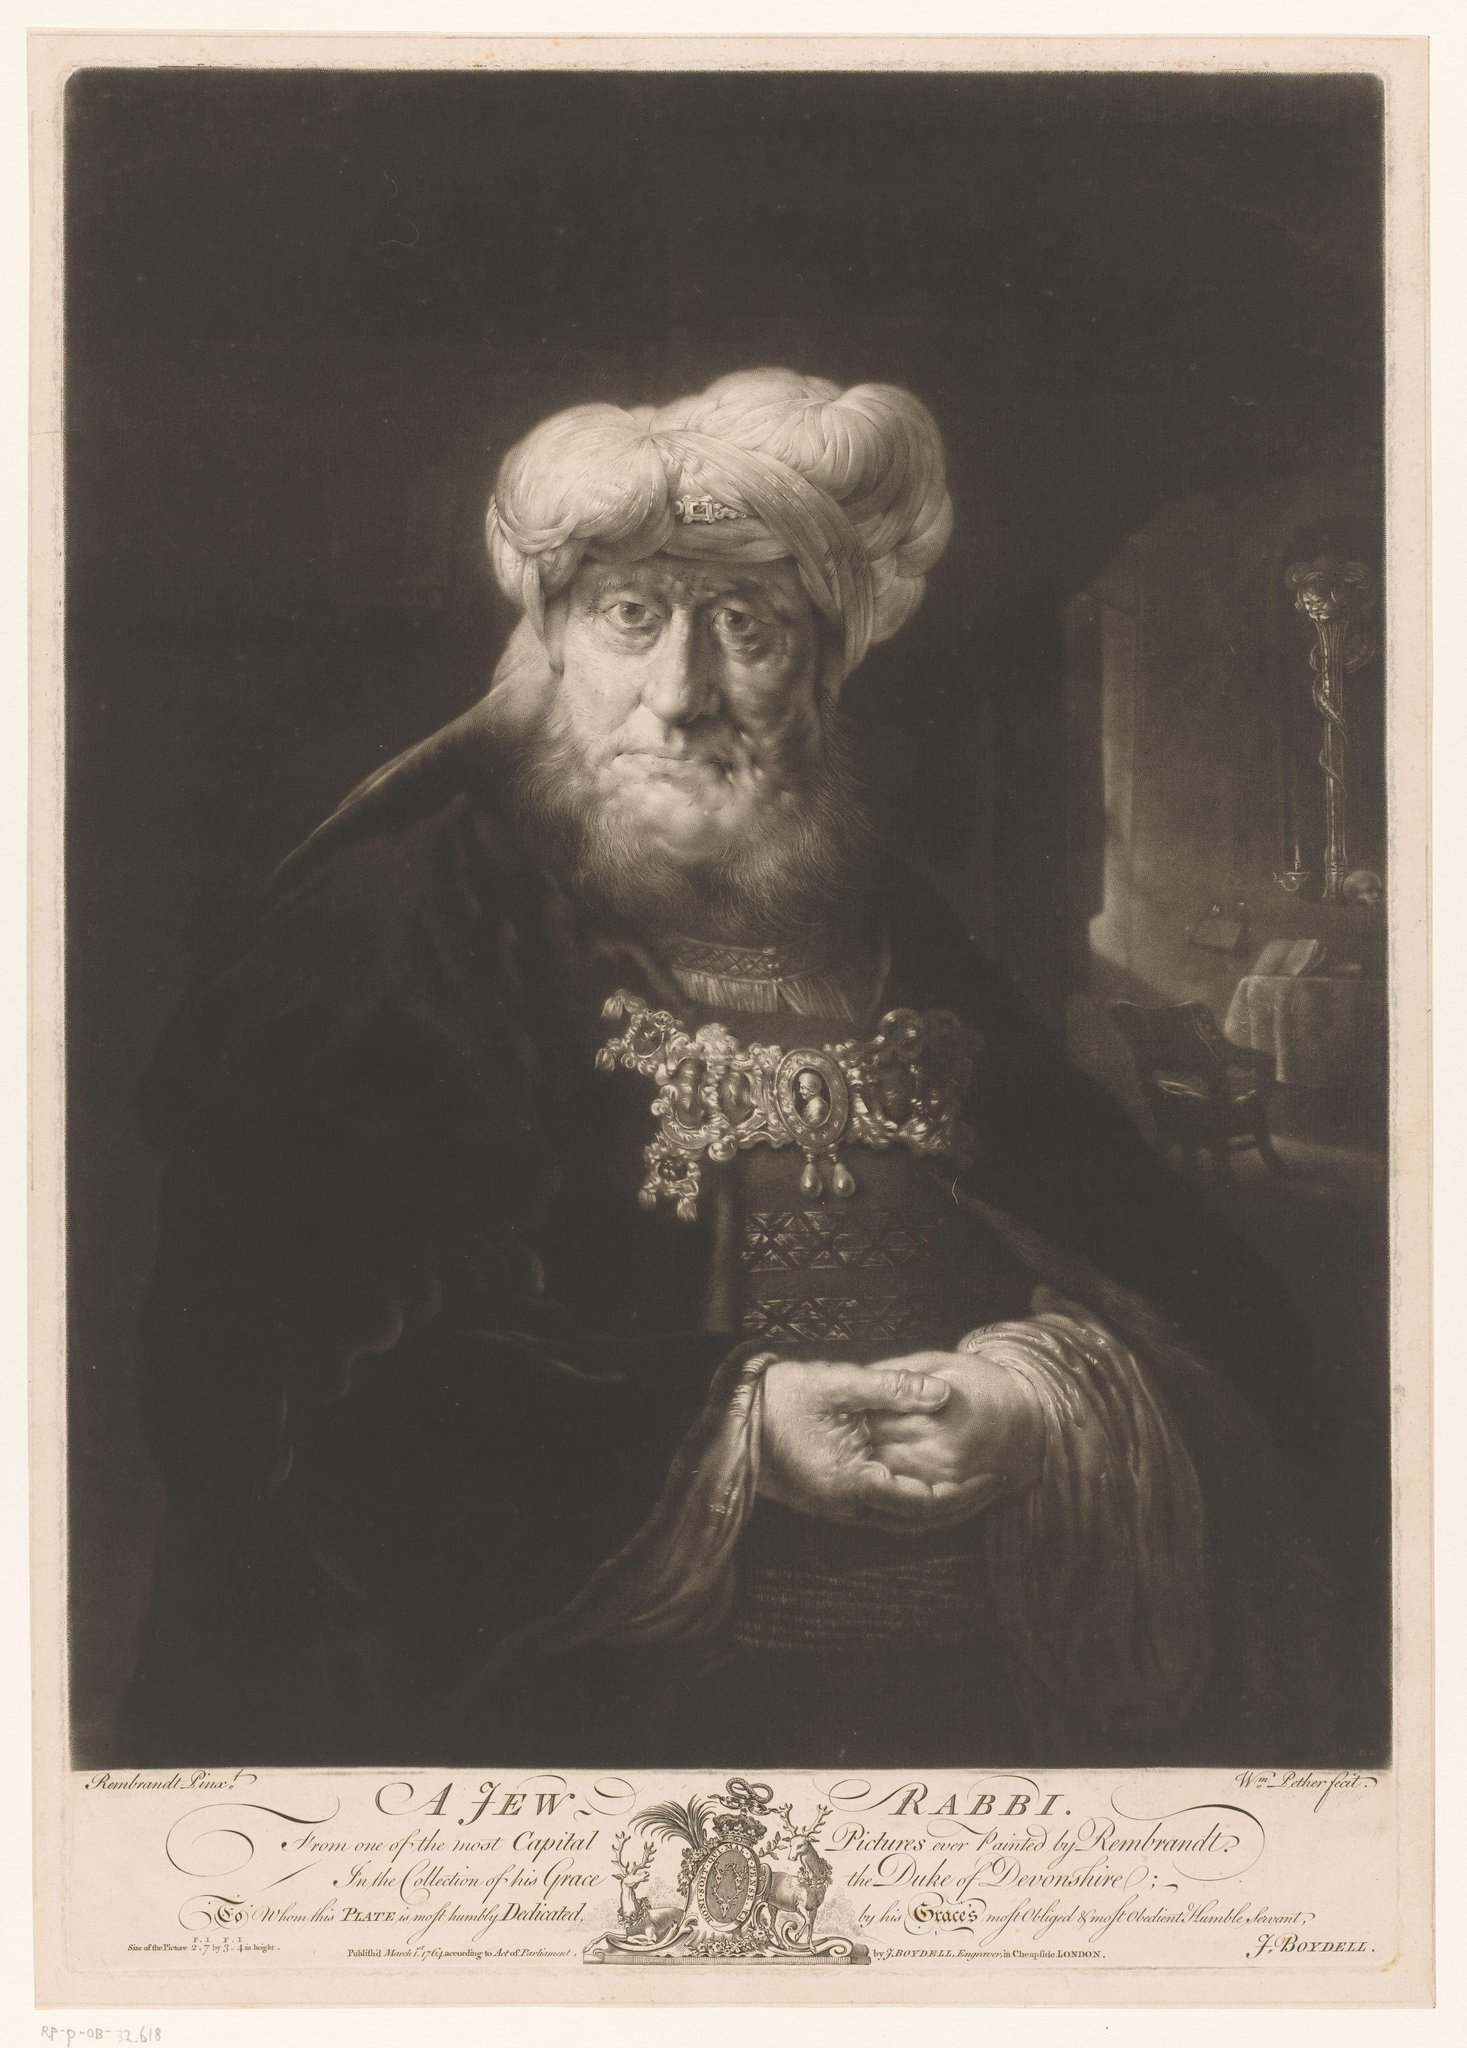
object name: print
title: Koning Uzziah geteisterd door melaatsheid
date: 1764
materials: paper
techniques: engraving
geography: london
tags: story of uzziah (azariah), son of amaziah, king of judah (2 kings 15:1-7; 2 chronicles 26), chief rabbi, leprosy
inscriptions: collector's mark: Lugt 240